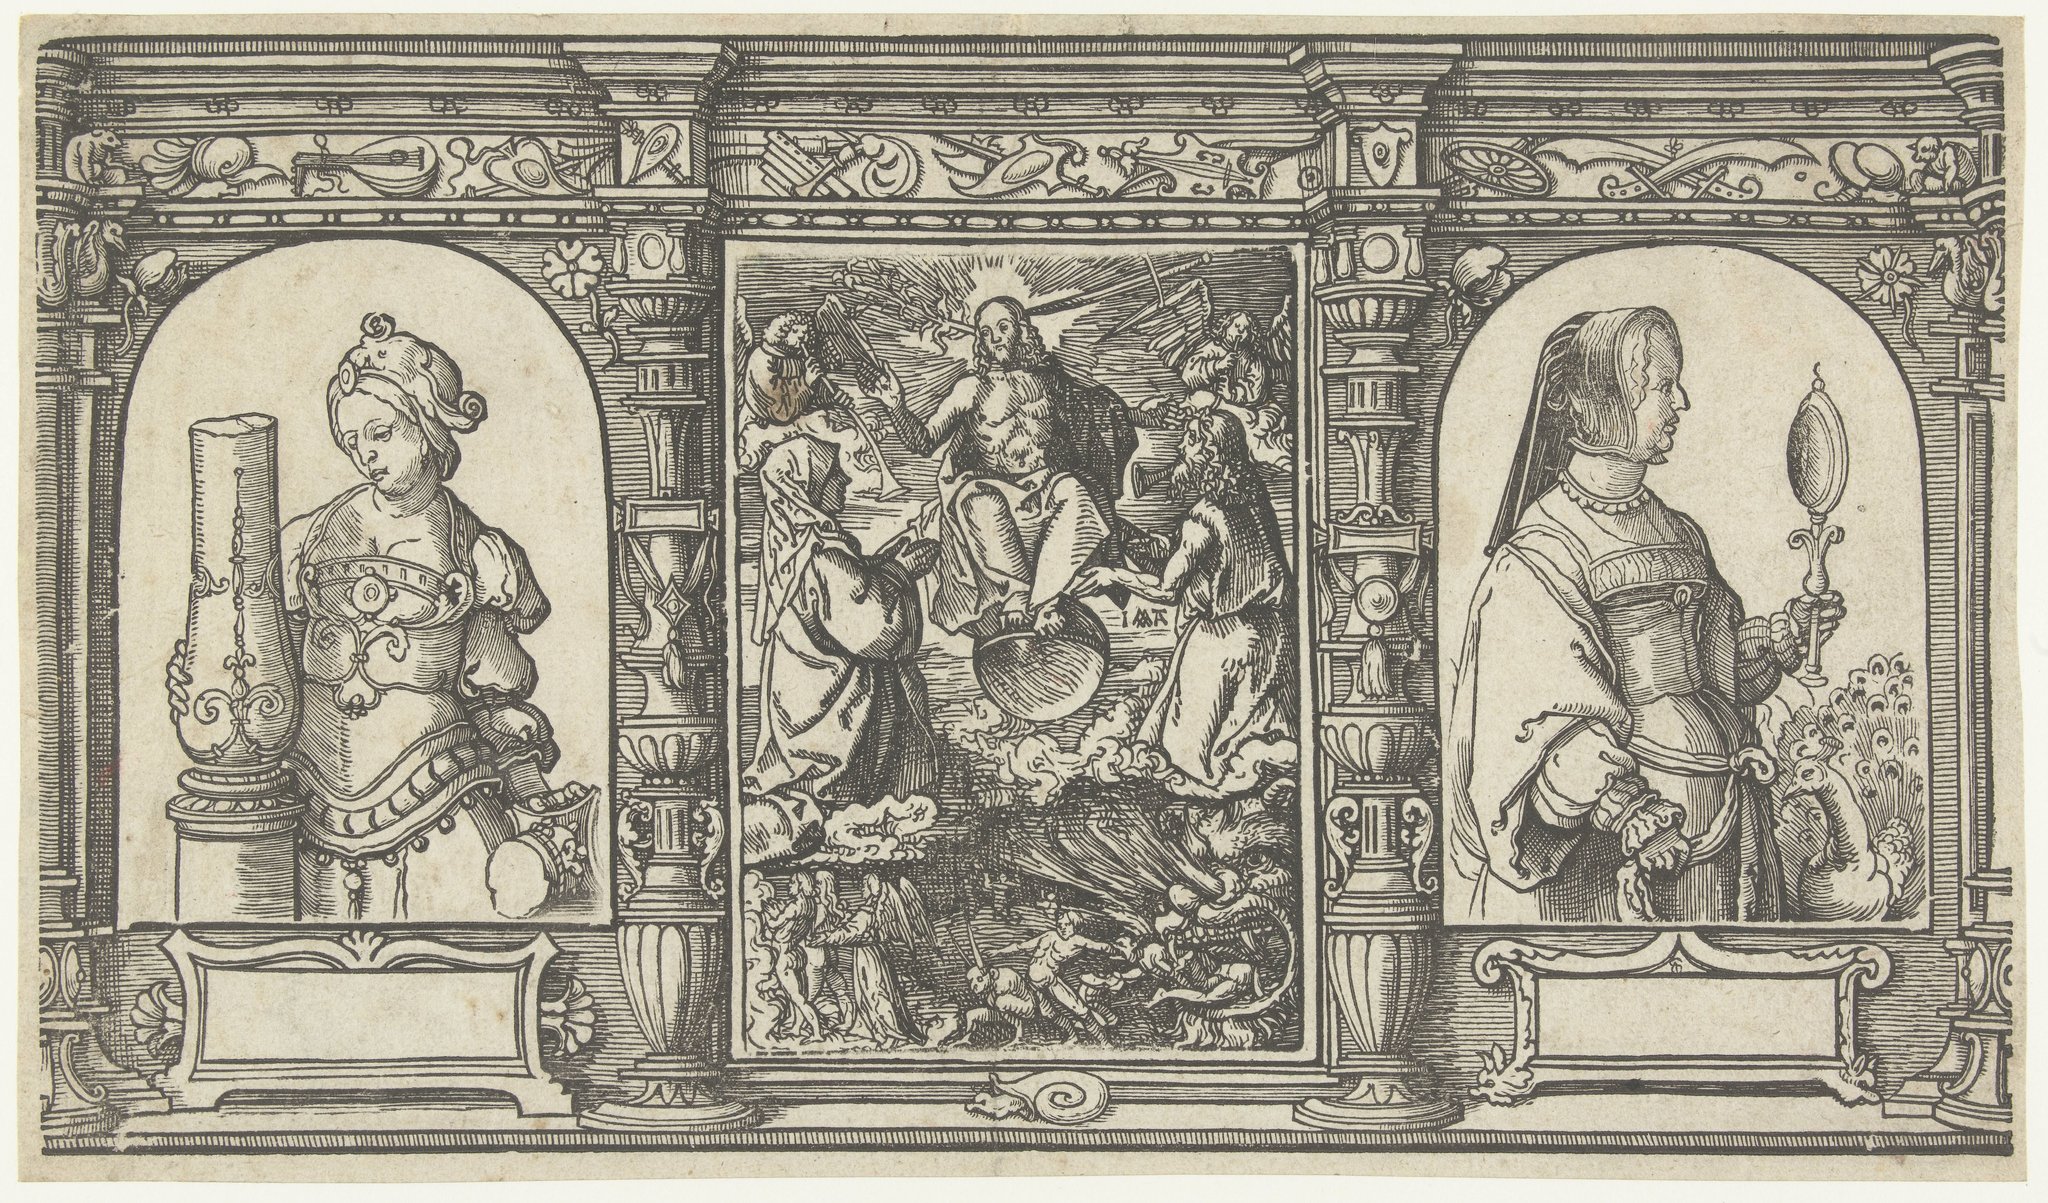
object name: print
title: Het Laatste Oordeel en personificaties van Kracht (Fortitudo) en IJdelheid (Vanitas)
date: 1520-1521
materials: paper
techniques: woodcut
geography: low countries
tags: fortitude, 'fortitudo' ~ one of the four cardinal virtues, (personifications of) 'vanitas', the vanity of human life; fragilità humana, fugacità delle grandezze & della gloria mondana, meditatione della morte, opera vana, piacere vano, vana gloria, vanità (ripa), comprehensive representation of last judgement: christ (with sword and lily), often surrounded by elders and sometimes accompanied by mary and john the baptist, appears in the sky with trumpeting angels (and sometimes angels holding the instruments of the passion); after the resurrection of the dead the blessed are led to heaven by angels, and the damned are dragged into hell by devils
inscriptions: collector's mark: Lugt 240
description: Gedrukt van meerdere blokken, vormt één geheel door nieuwe omlijsting. Ook gebruikt als boekillustratie. Links personificatie van de kracht, vrouw met afgebroken zuil. Rechts personificatie van de ijdelheid, vrouw met spiegel en pauw. In het midden Laatste Oordeel.